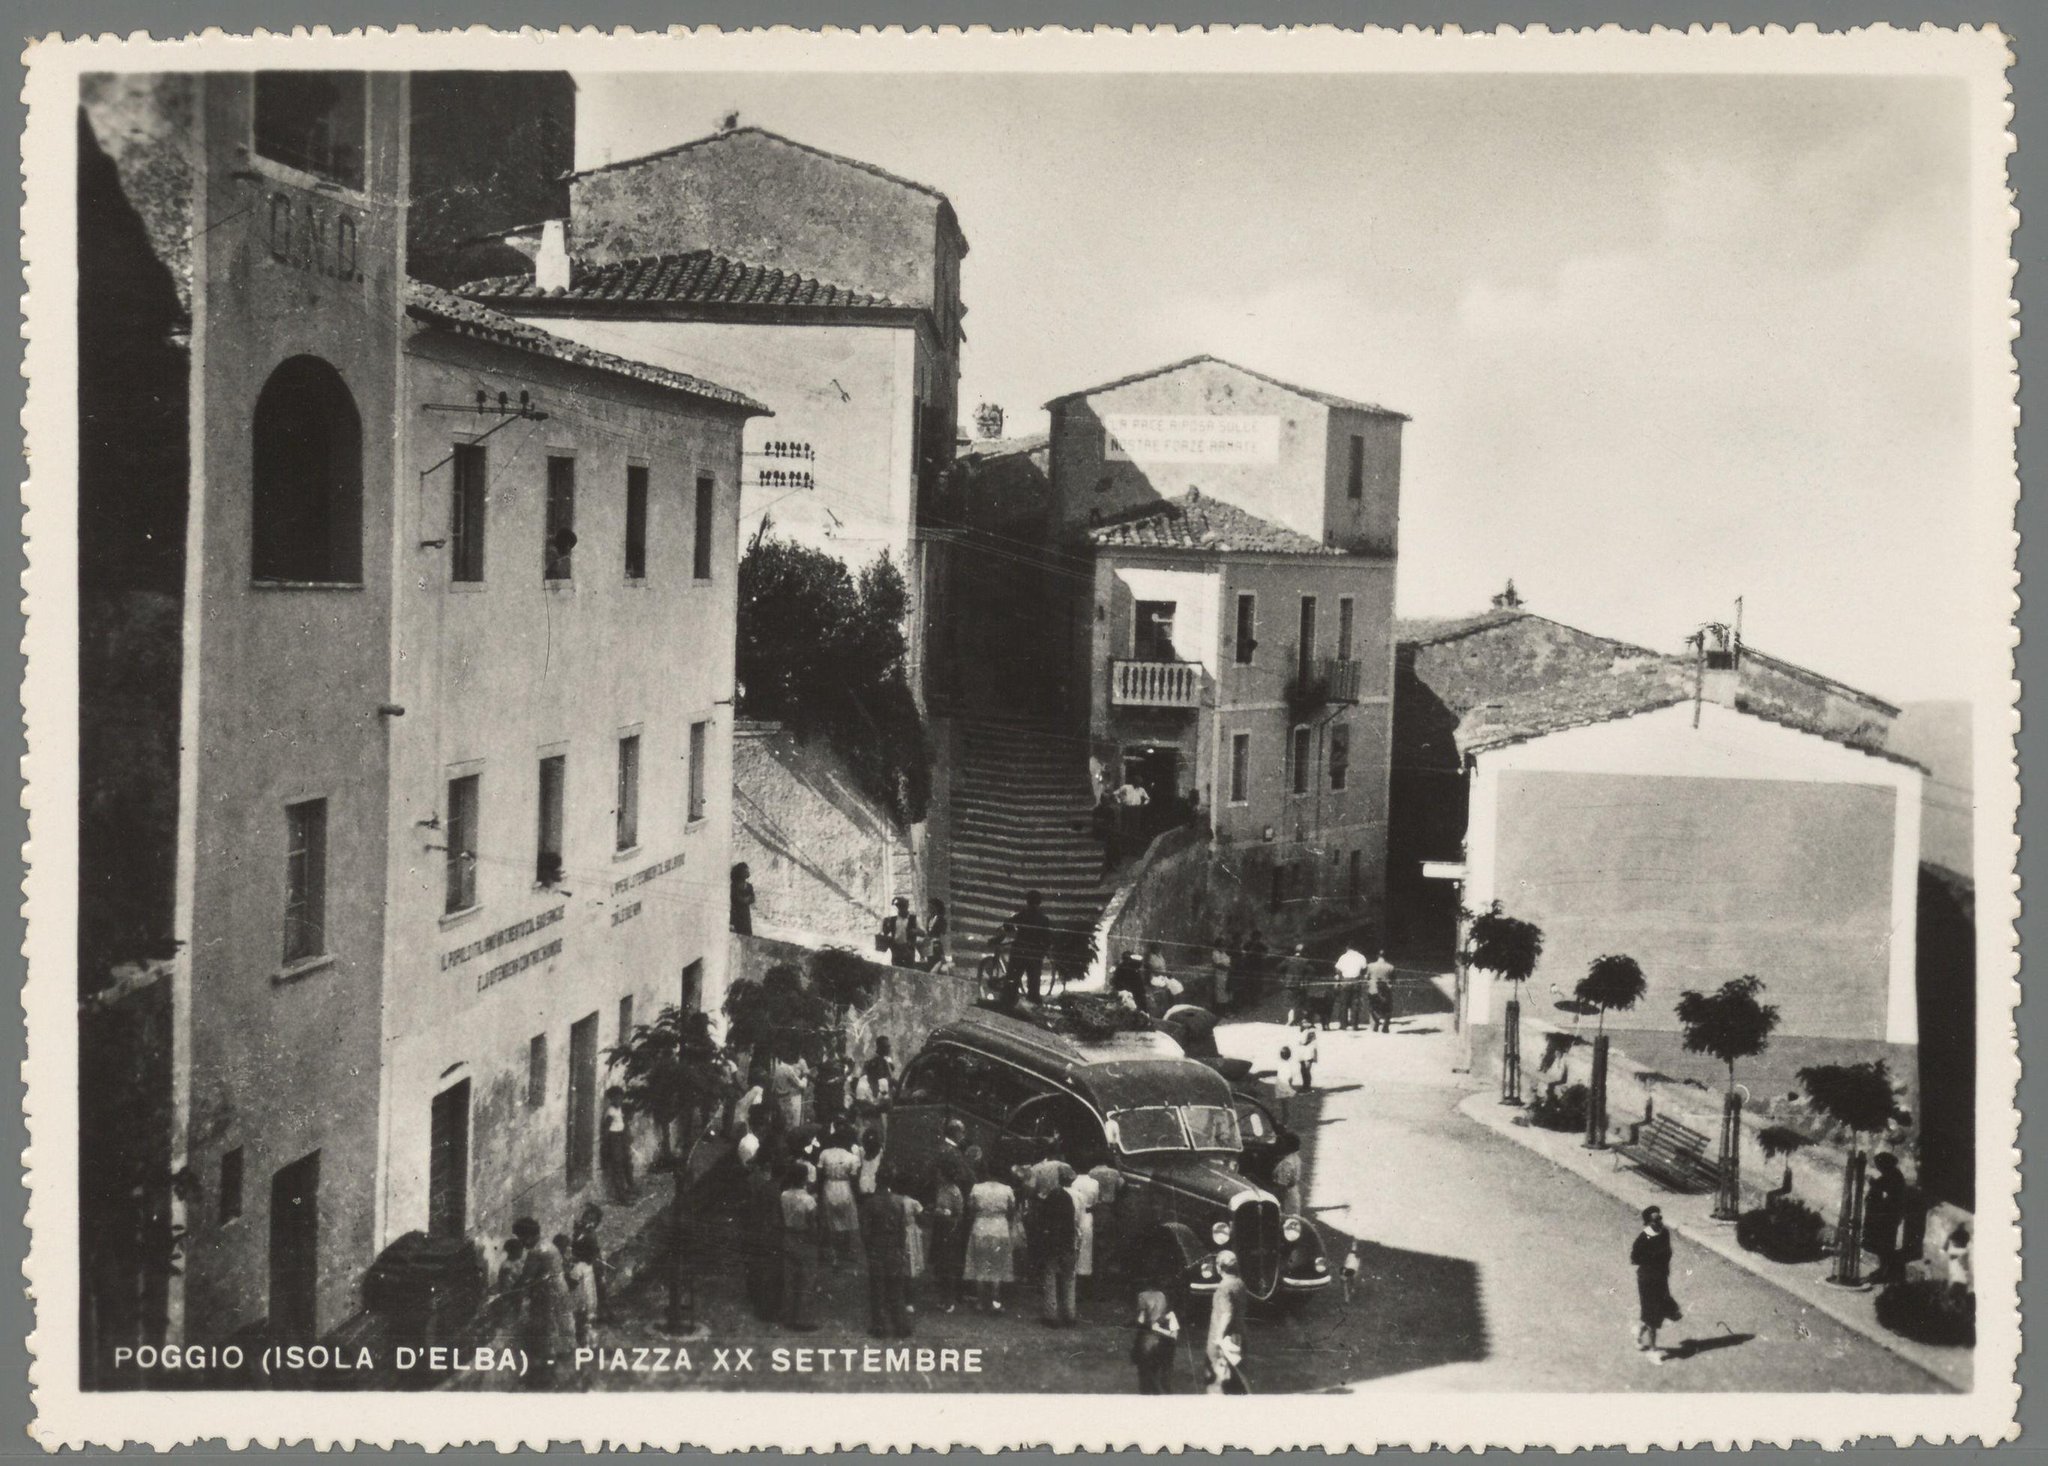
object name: ansichtkaart, prentbriefkaart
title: Poggio (Isola d'Elba). Piazza XX Settembre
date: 1935-1945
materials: photographic support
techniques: photography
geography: poggio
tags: village (+ city(-scape) with figures, staffage)